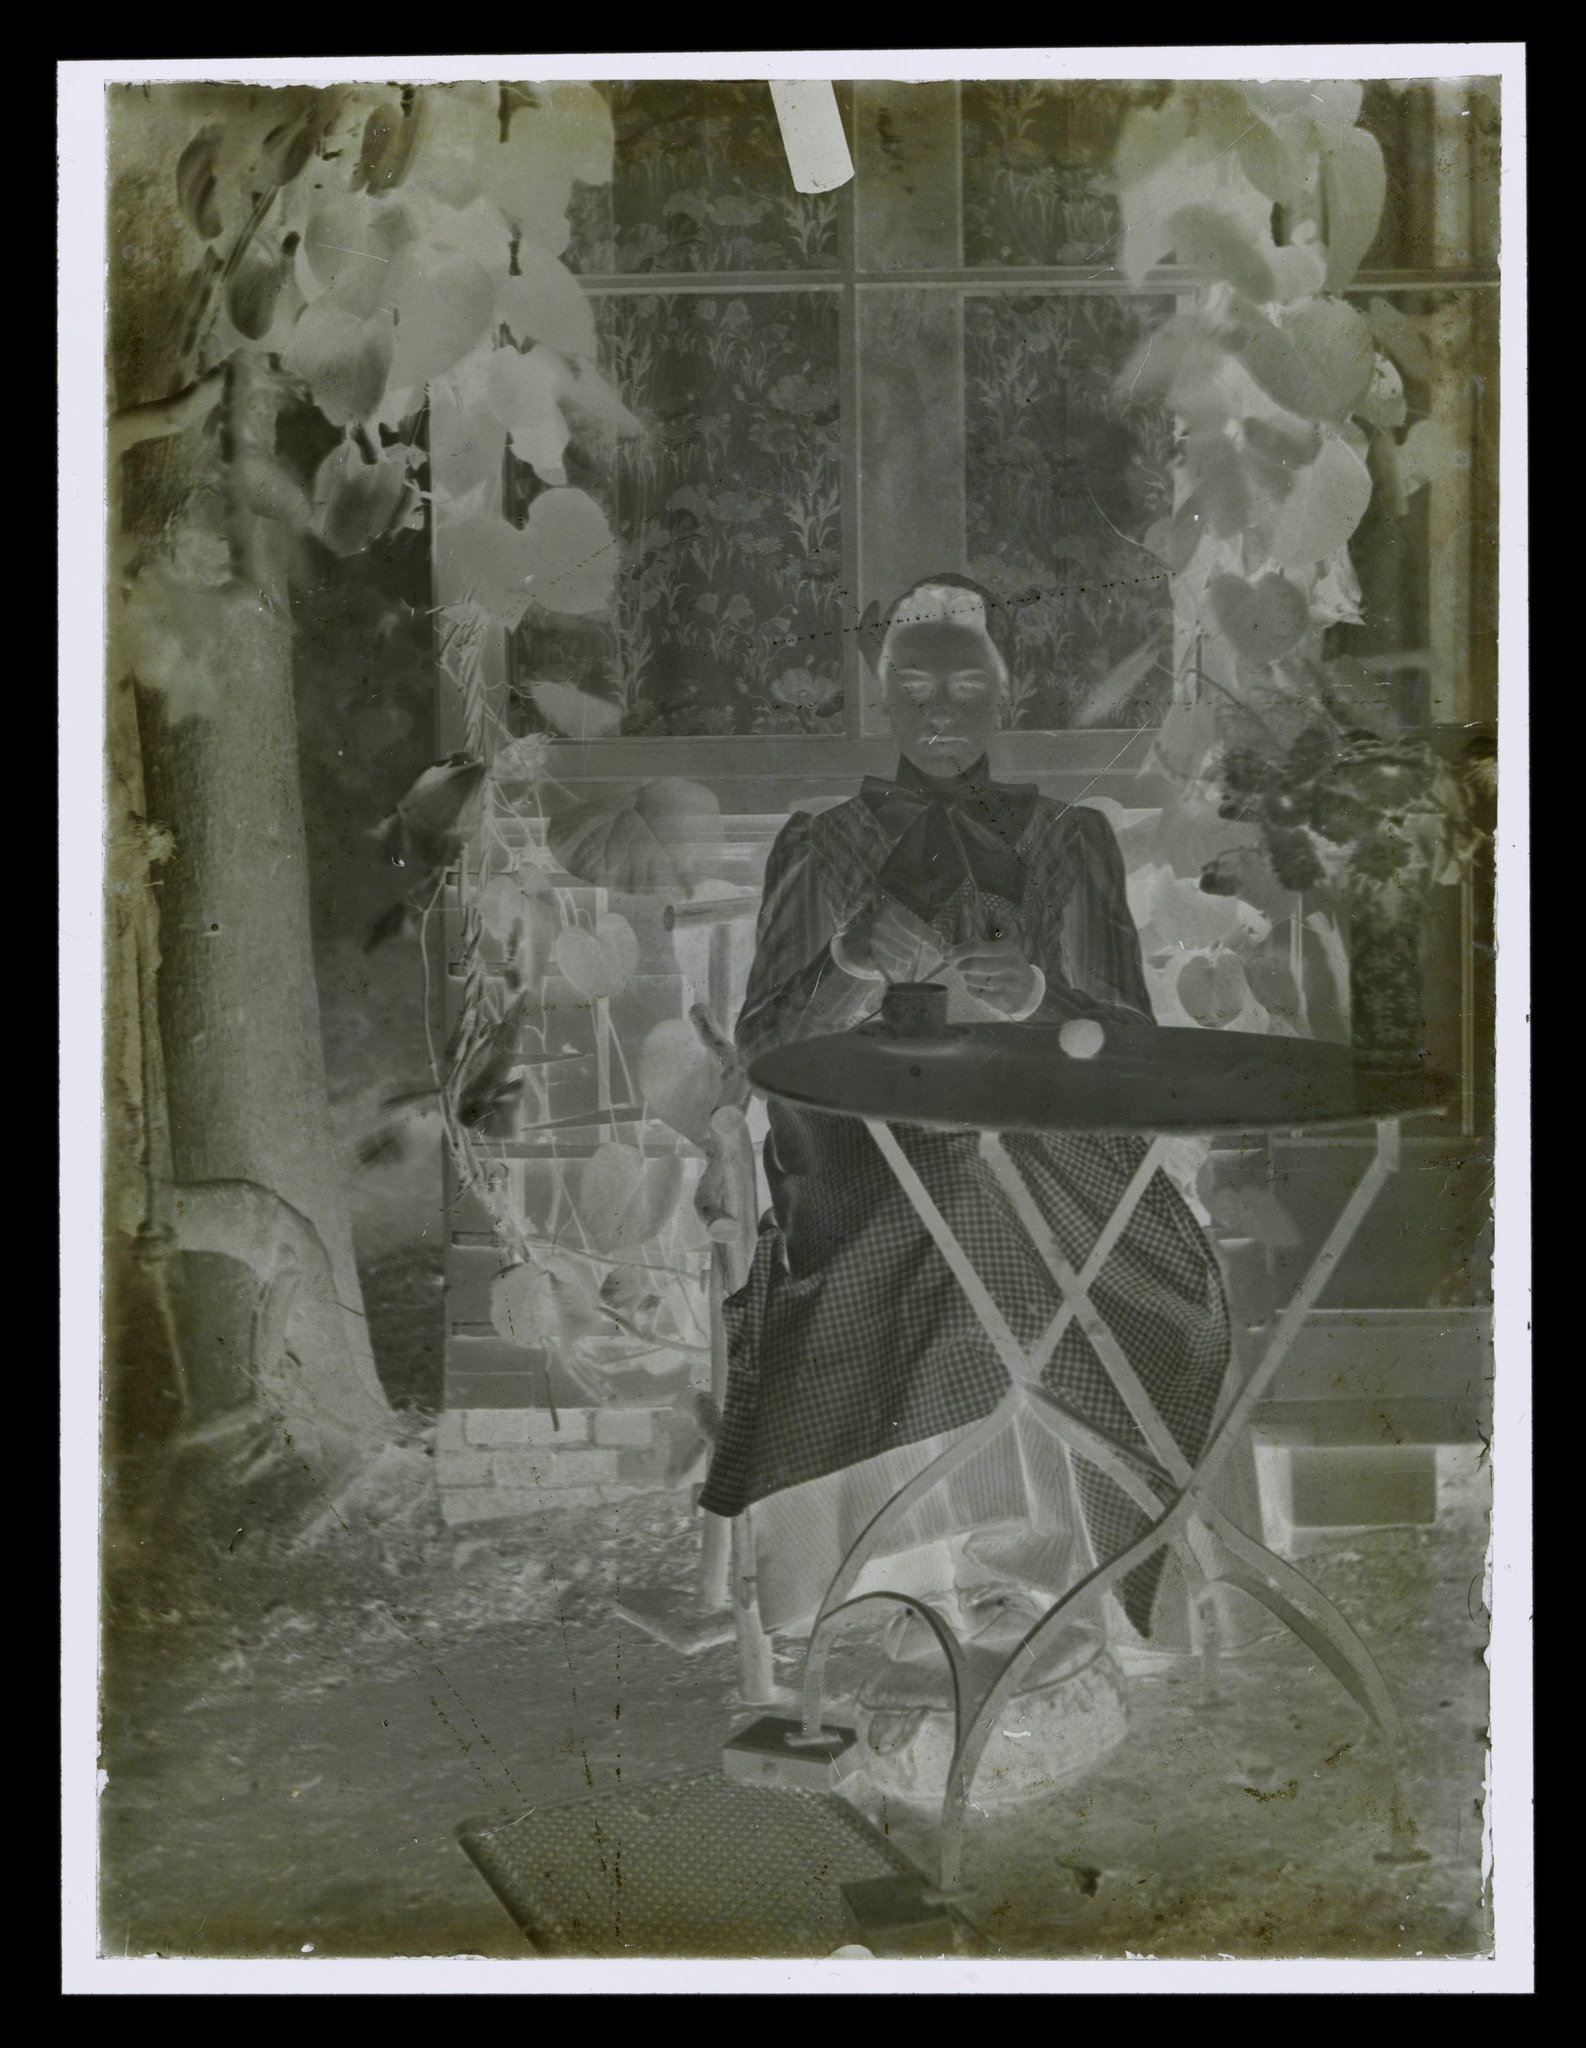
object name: glasnegatief, glasplaatnegatief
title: Portret van een onbekend meisje dat buiten theedrinkt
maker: laurens lodewijk kleijn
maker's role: draughtsman, painter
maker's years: 1826-1909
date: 1865-1900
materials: glass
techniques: collodion process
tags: adolescent, young woman, maiden, historical persons, cup of tea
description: Onderdeel van groep glasnegatieven uit de nalatenschap van de schilder Laurens Lodewijk Kleijn, stillevens, portretten, zelfportretten en kunstreproducties.